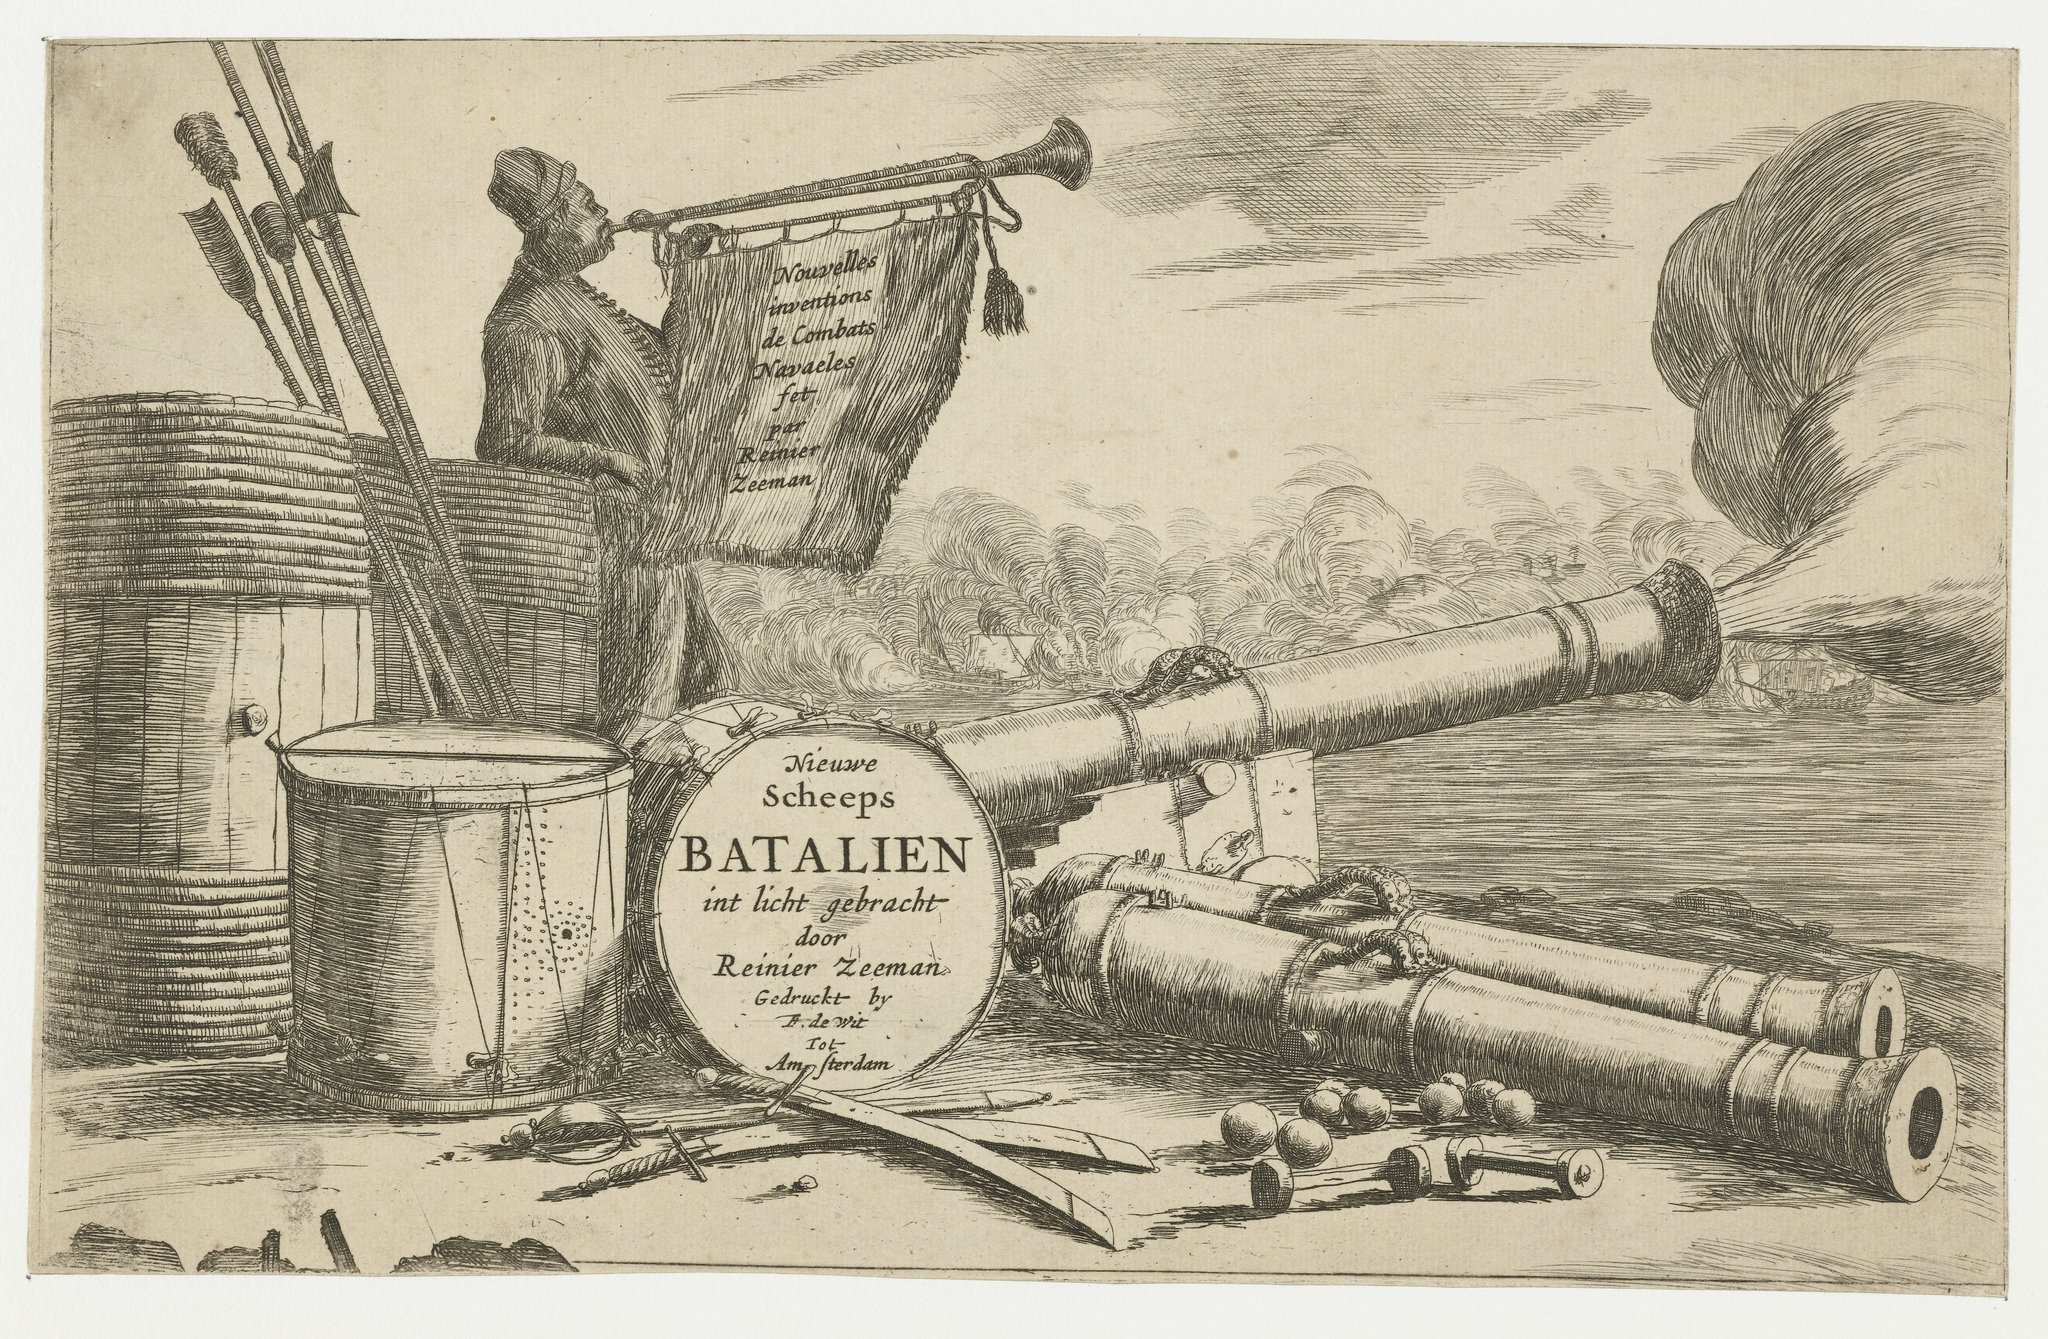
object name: print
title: Nieuwe Scheeps Batalien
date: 1652-1656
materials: paper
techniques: drypoint, etching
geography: low countries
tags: title-page, warfare; military affairs (+ naval force)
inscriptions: collector's mark: Lugt 2228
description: Titelblad voor een reeks van zeeslagen. De uitrusting van een oorlogsschip waaronder kanonnen, kogels, kruitvaten en twee trommels. Een zeeman blaast op een trompet waaraan een vlag hangt.